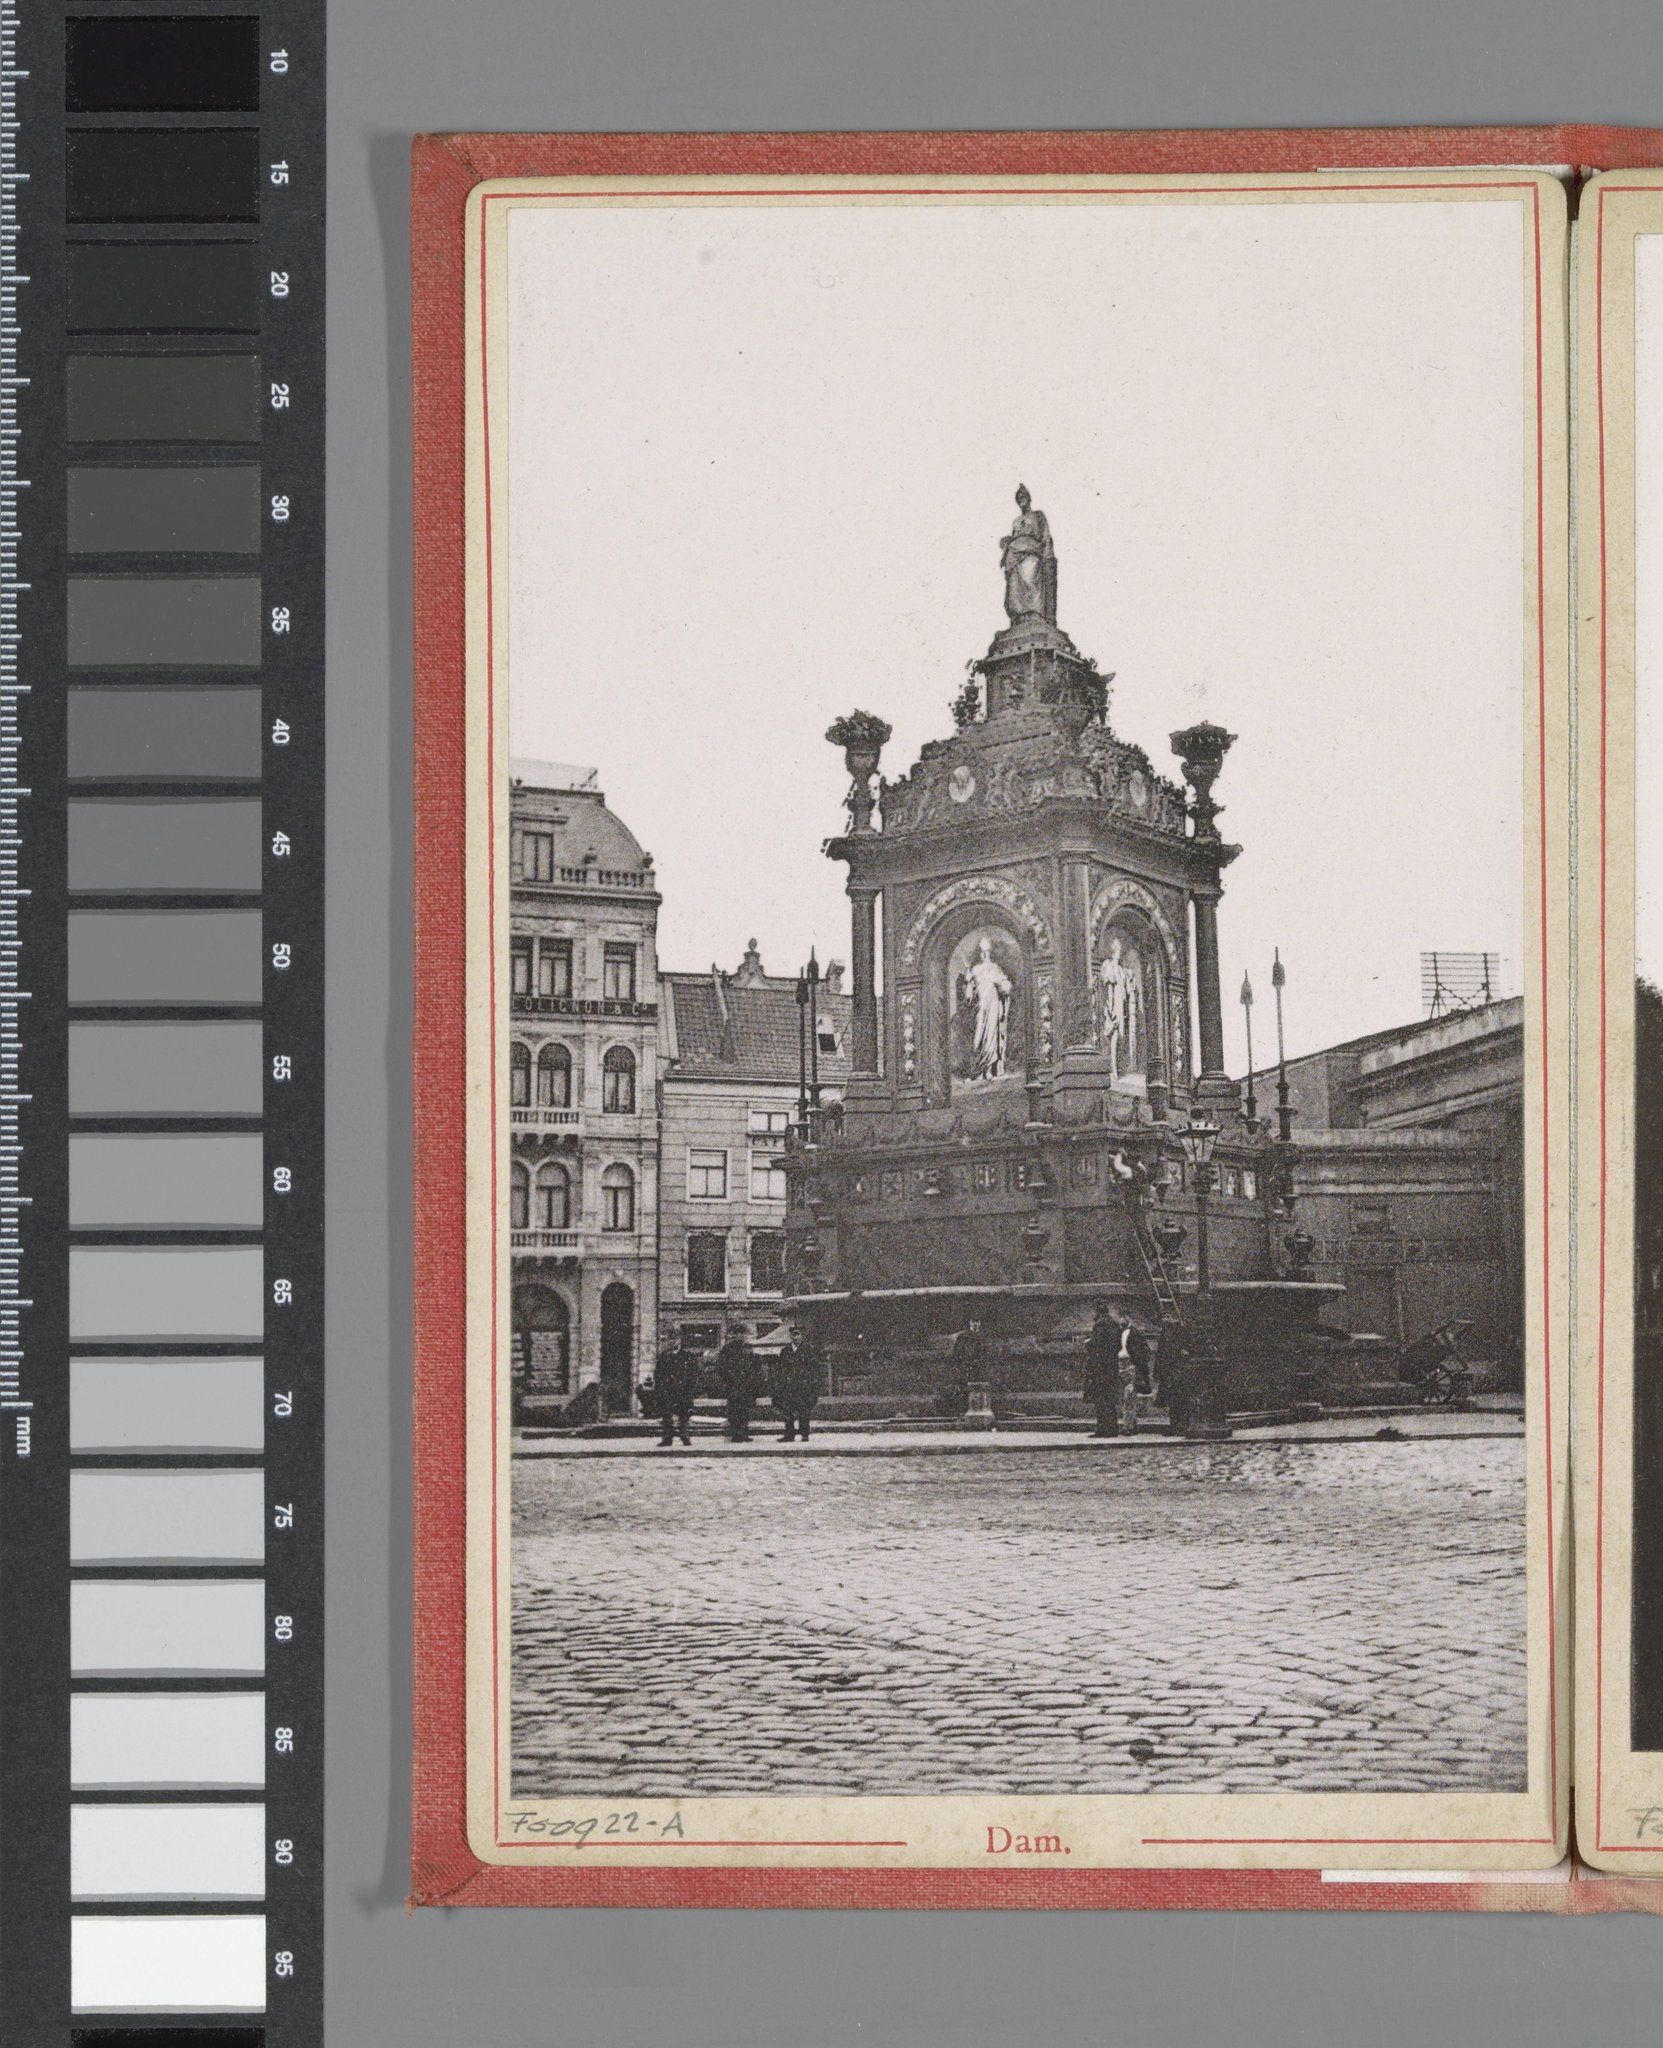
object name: cabinet photograph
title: Dam.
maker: Anonymous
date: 1804-1887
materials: cardboard, paper, ink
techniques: photograph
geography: amsterdam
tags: monument, statue, prospect of city, town panorama, silhouette of city, amsterdam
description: Onderdeel van Fotoalbum met opnames van de Aprilfeesten in 1887 te Amsterdam.